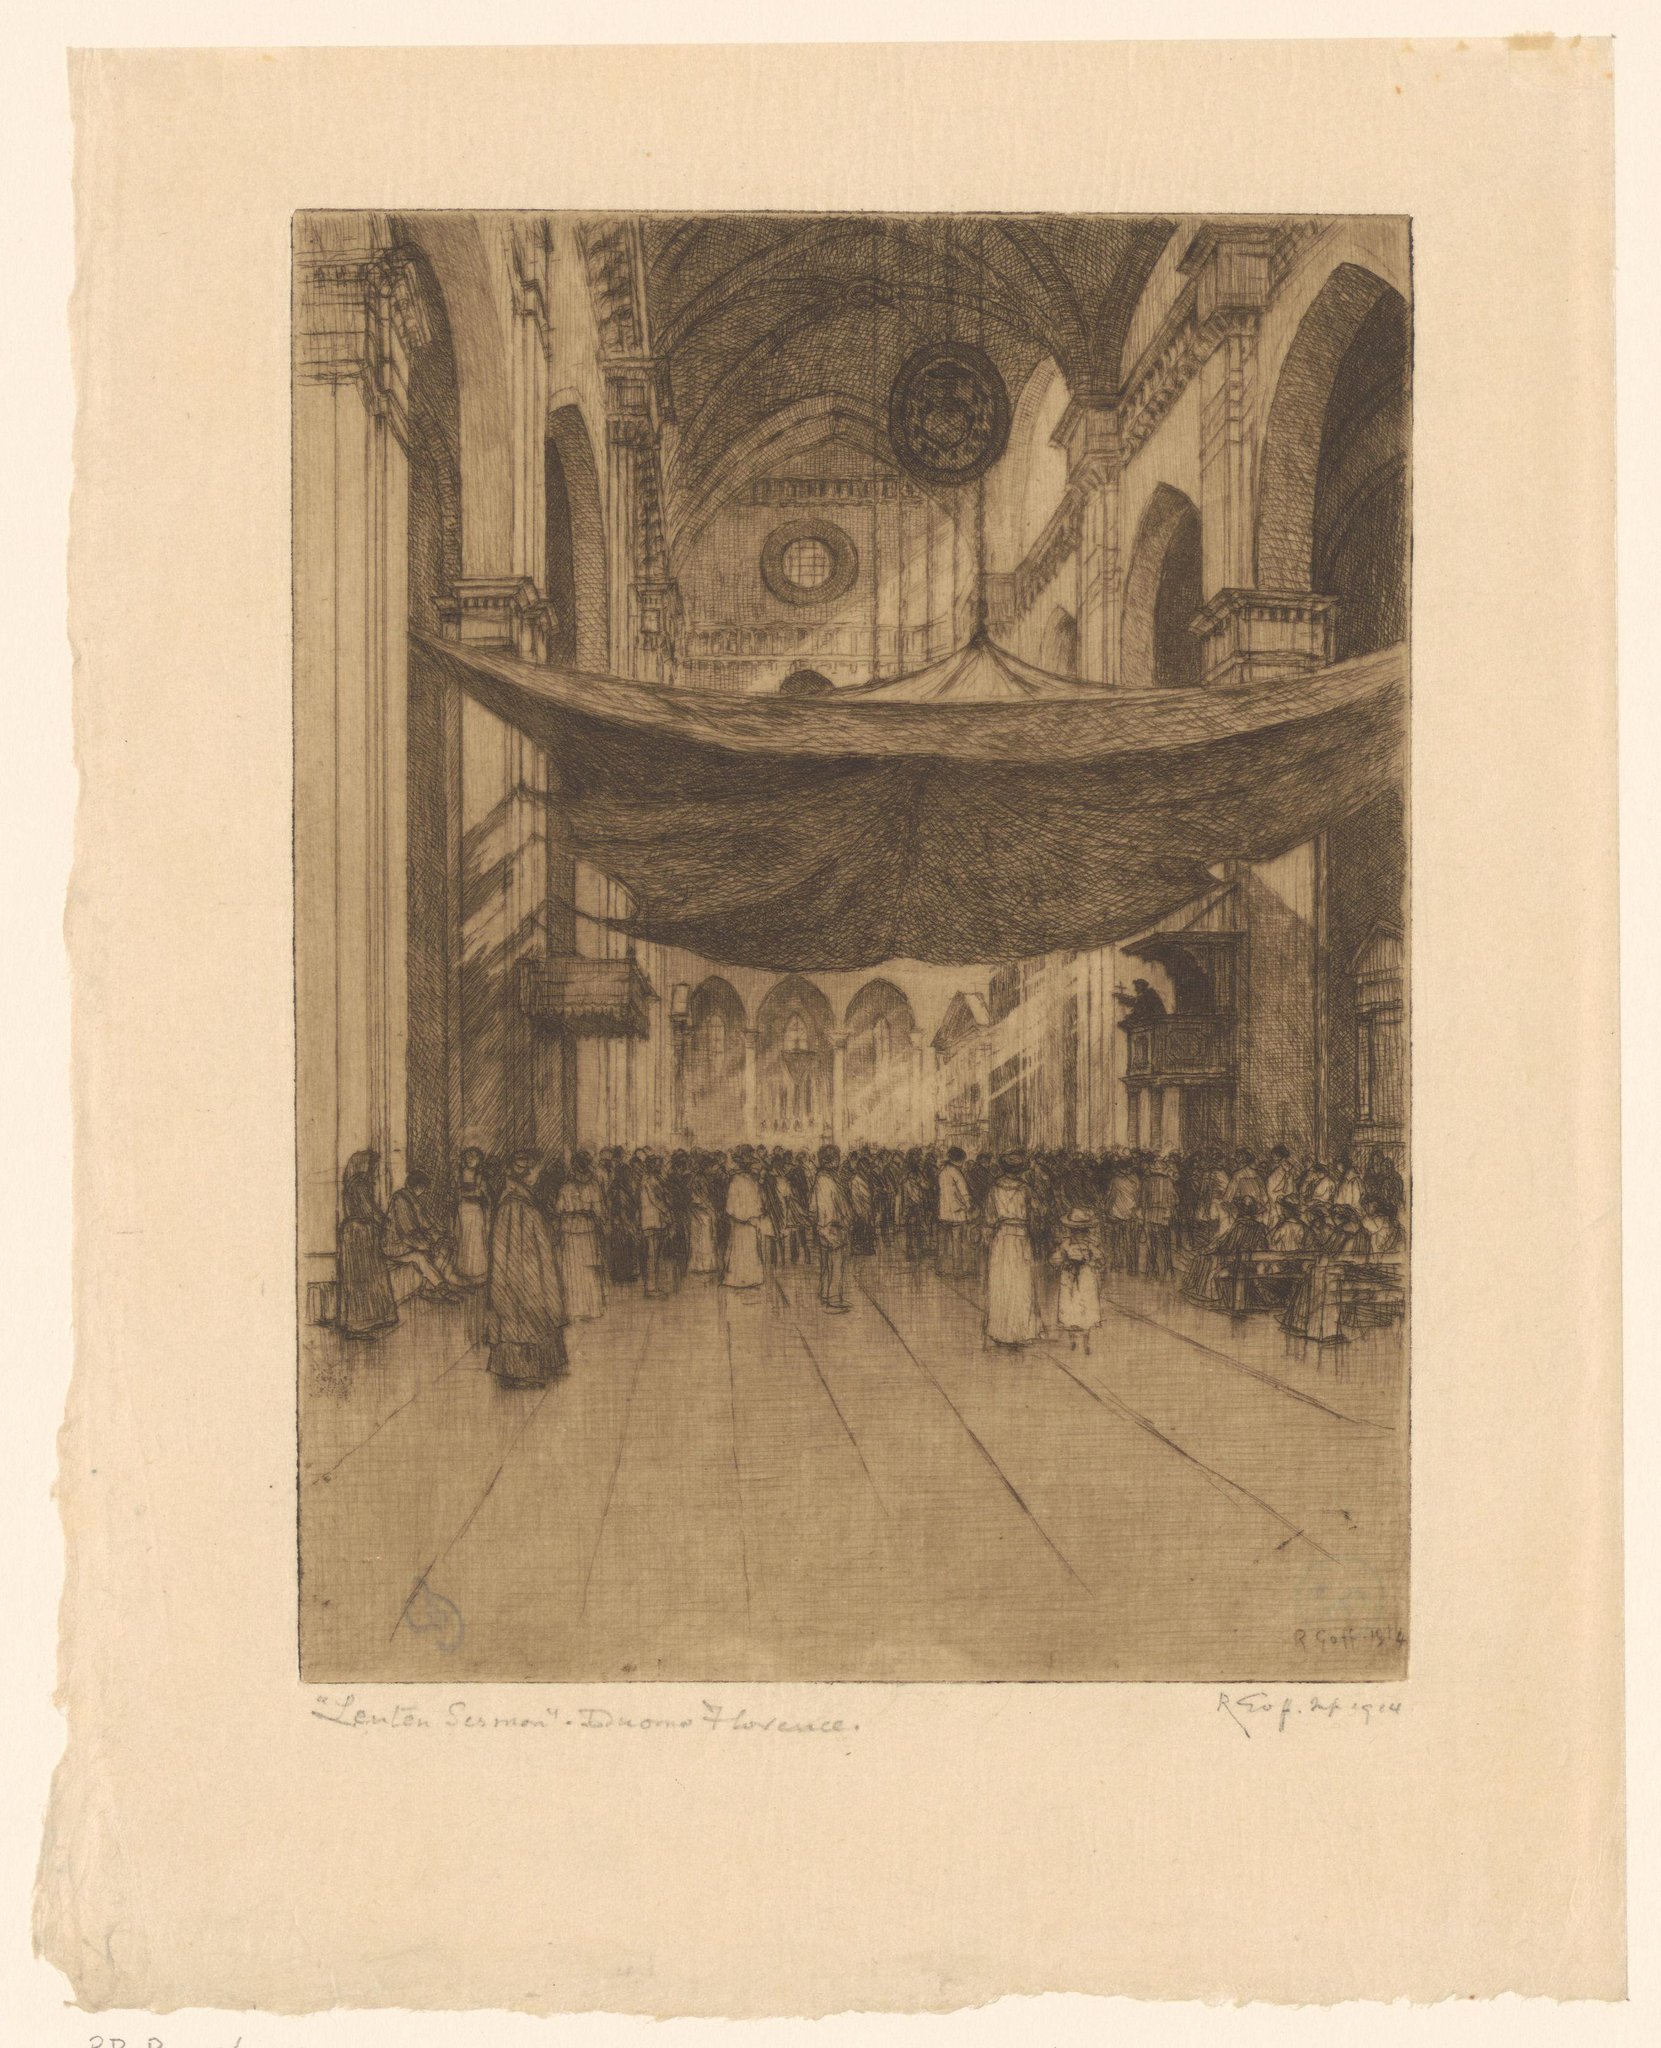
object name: print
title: Preek in de Dom van Florence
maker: robert charles goff (1837-1922)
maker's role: painter, print maker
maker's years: 1837-1922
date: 1914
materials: paper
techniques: drypoint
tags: liturgical furniture, etc., interior of church, preaching (in general)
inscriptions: collector's mark: Lugt 4731, collector's mark: Lugt 2228, collector's mark: Lugt 5101, annotation: ‘Lenton Sermon, Duomo Florence’, collector's mark: Lugt 2760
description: Een priester met crucifix op de preekstoel; publiek onder een baldakijn.